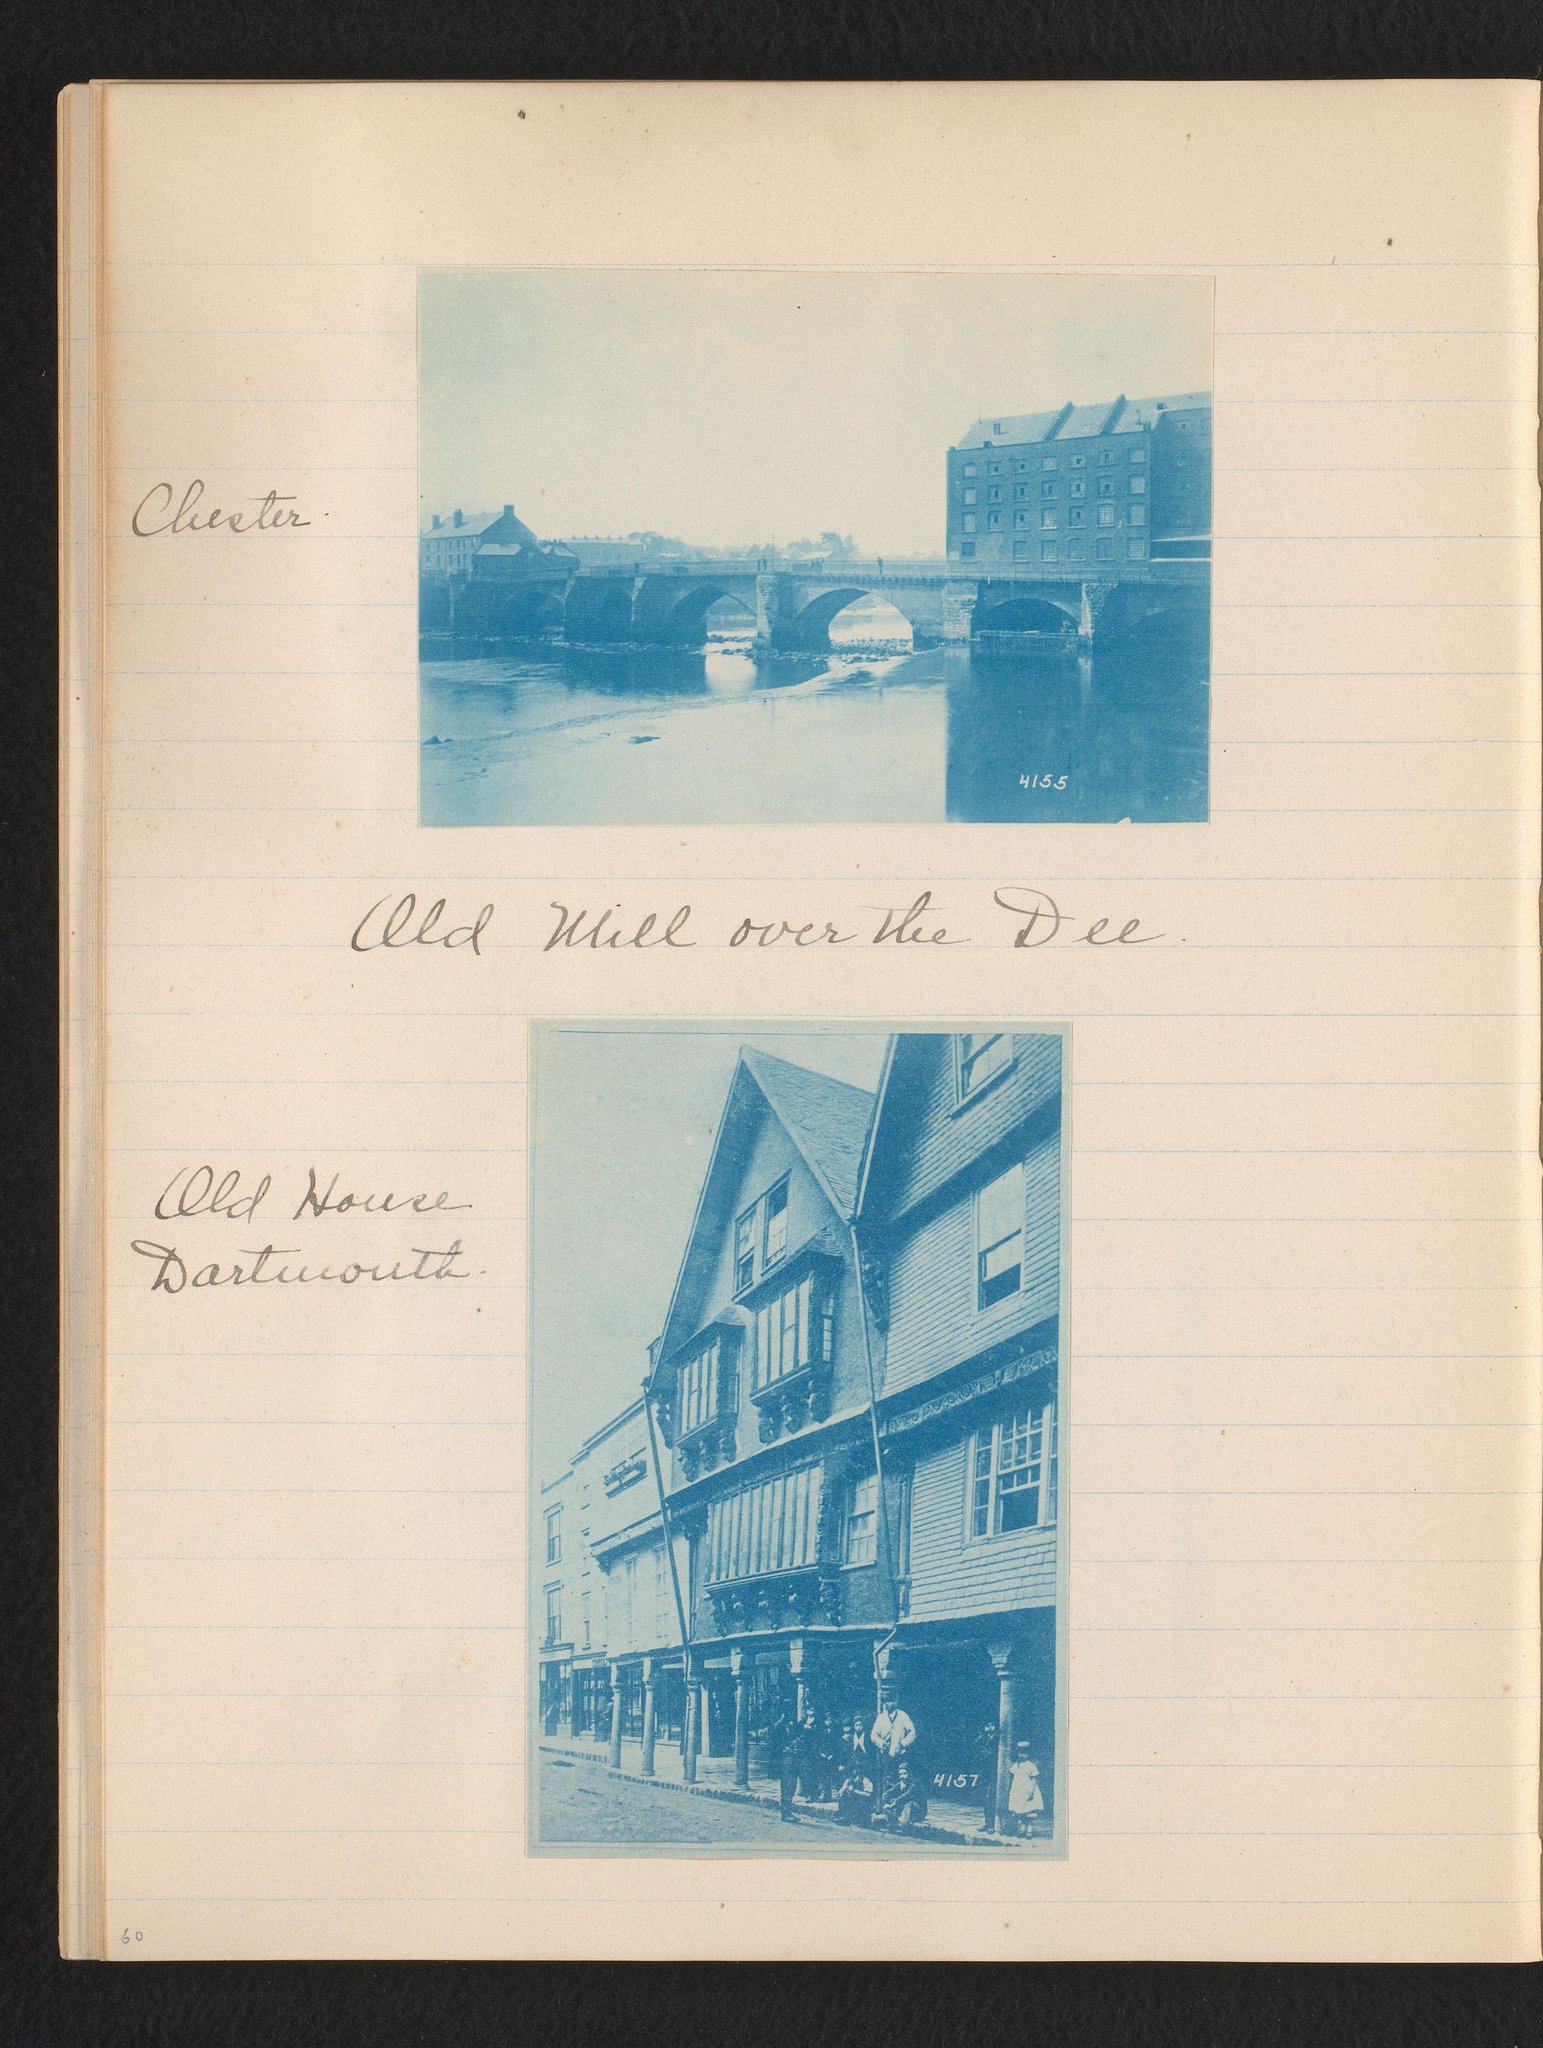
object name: album leaf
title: Twee foto's van Chester en Dartmouth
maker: Anonymous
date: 1901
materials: paper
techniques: cyanotype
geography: england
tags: house combined with shop, bridge in city across river, canal, etc.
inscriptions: inscription: ‘Chester./ Old Mill over the Dee./ Old House./ Dartmouth.’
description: Deze foto's maken deel uit van een album.